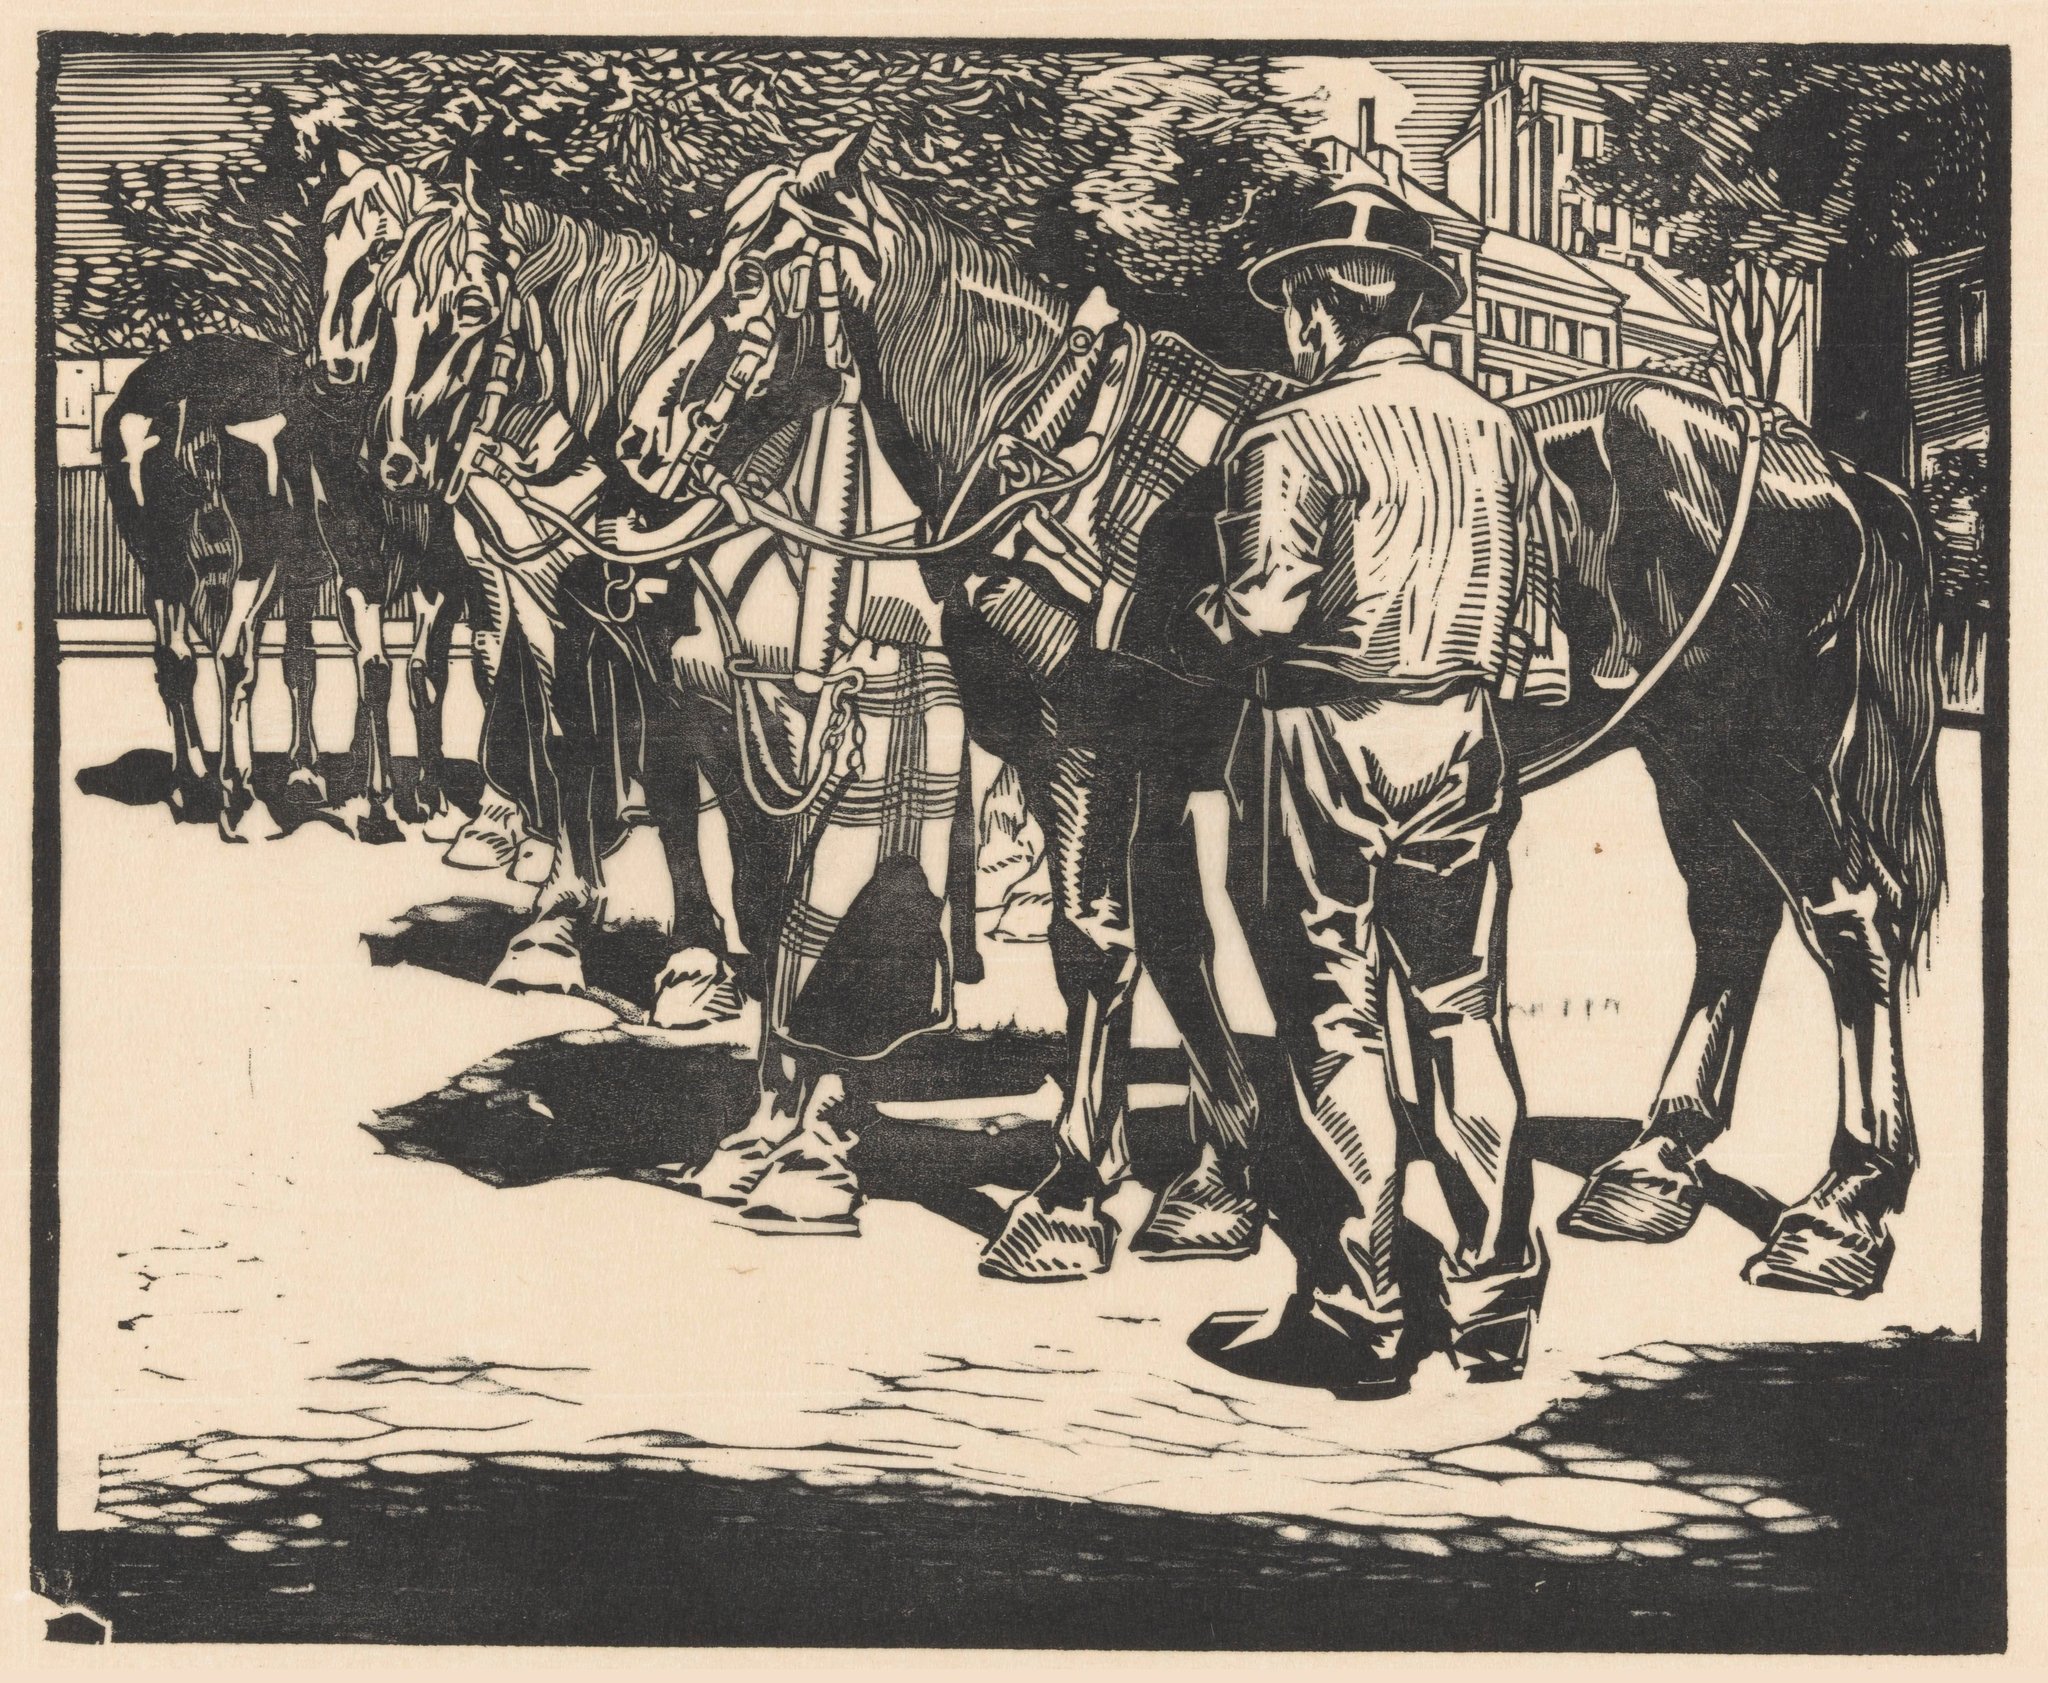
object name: print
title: Vier omnibus-paarden op een plein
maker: johannes josephus aarts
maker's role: draughtsman, print maker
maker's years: 1871-1934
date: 1901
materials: paper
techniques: woodcut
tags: diligence, omnibus, horse-tram, horse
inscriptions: collector's mark: Lugt 2228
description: Omnibus-paarden op een plein, met daaromheen huizen en bomen. Op de voorgrond een man met hoed, de voerman, op de rug gezien.